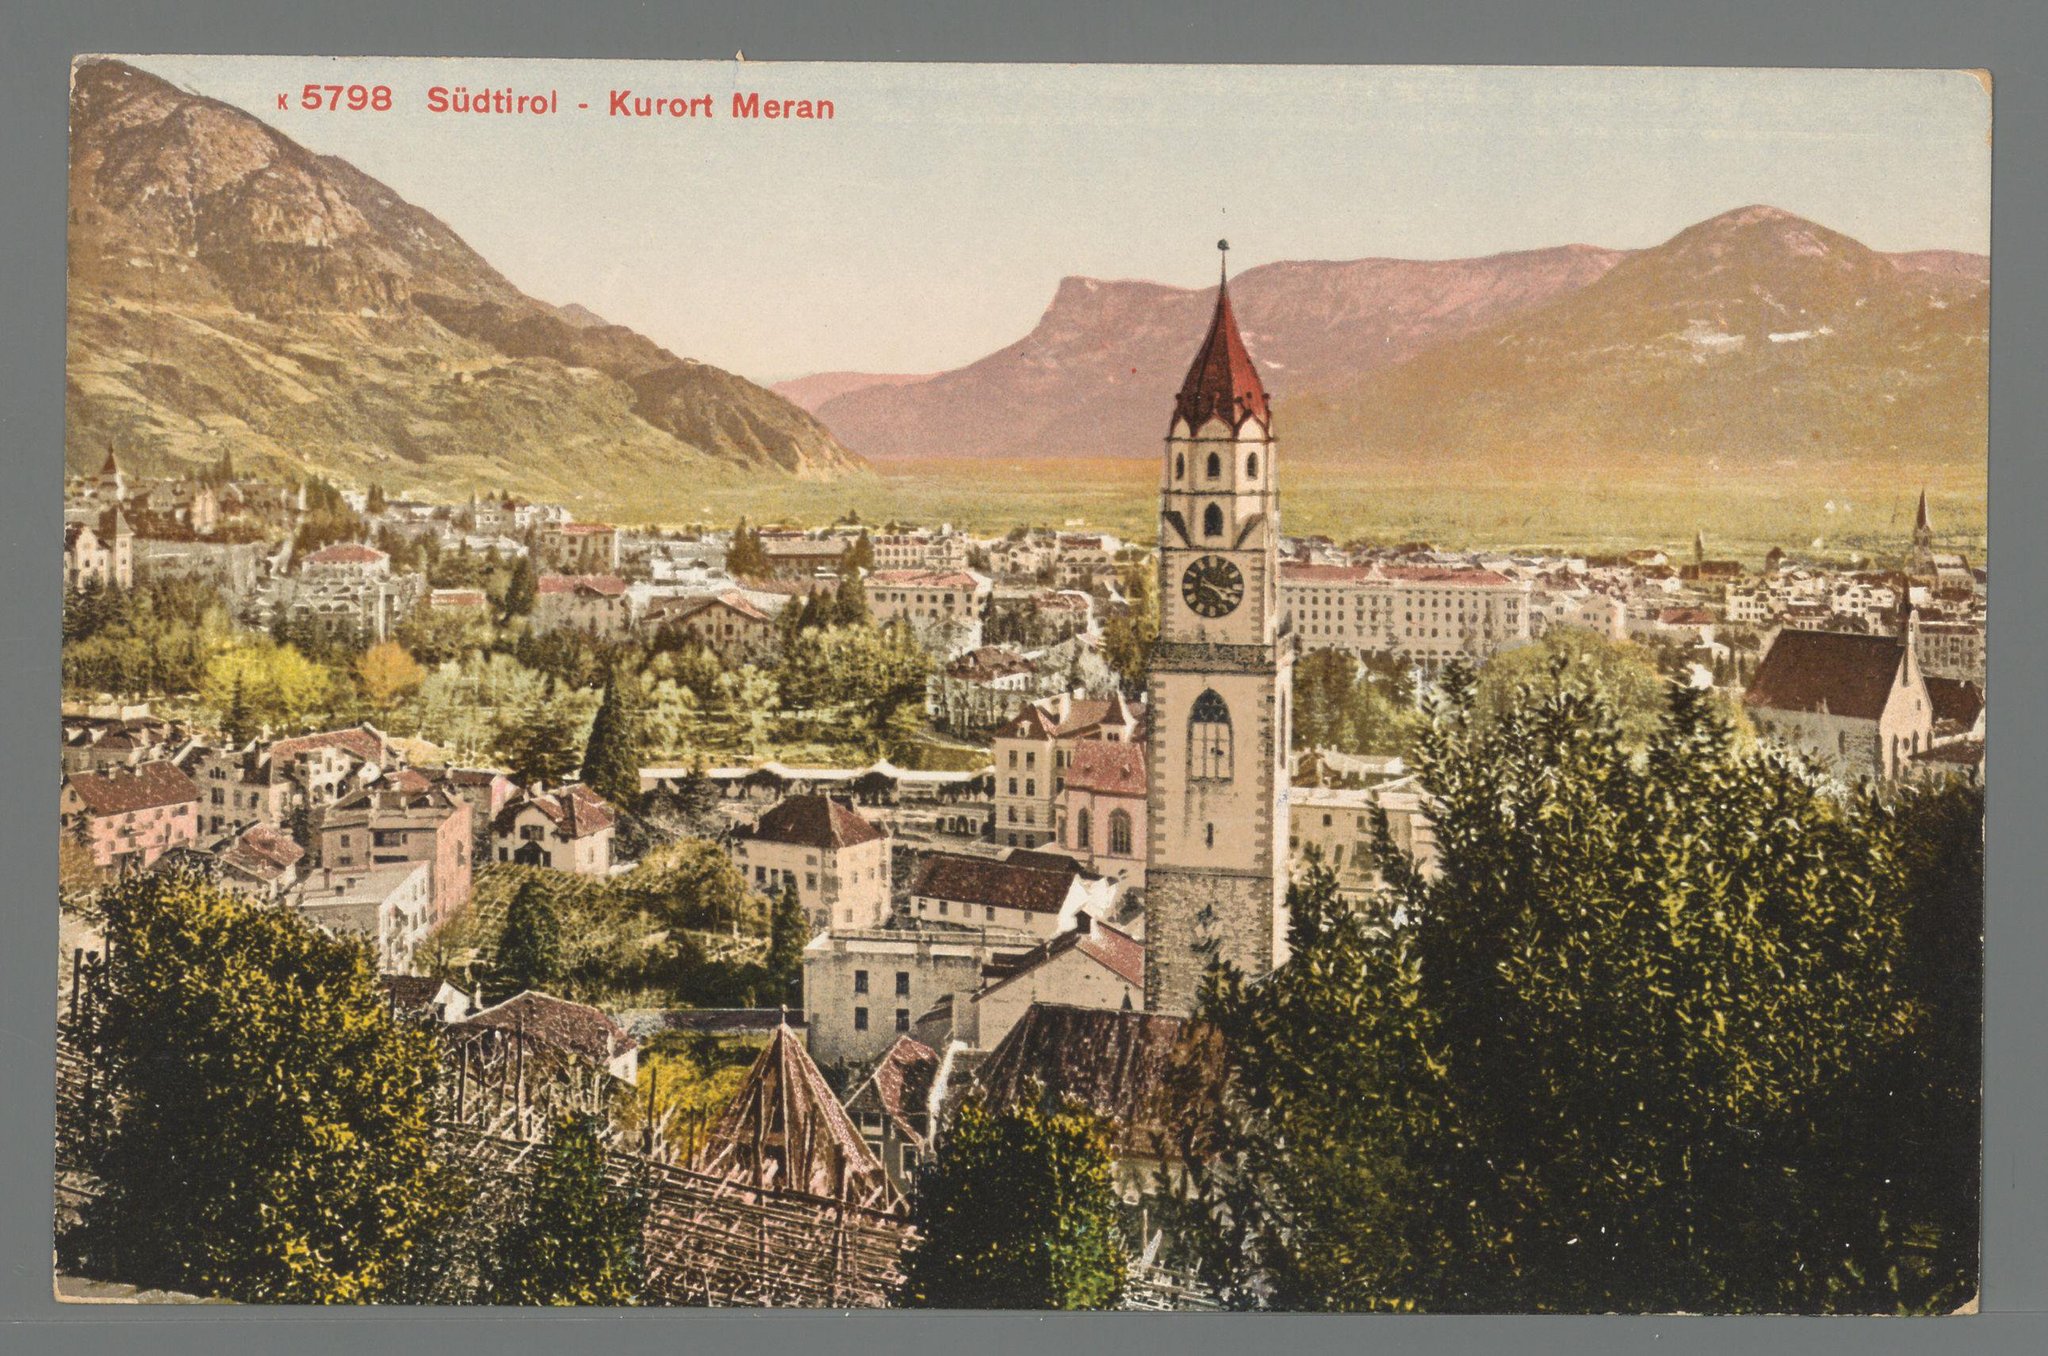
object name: photomechanical print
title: Südtirol. Kurort Meran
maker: Anonymous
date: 1905-1930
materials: cardboard, photographic process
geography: merano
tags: church (exterior), prospect of city, town panorama, silhouette of city, mountains